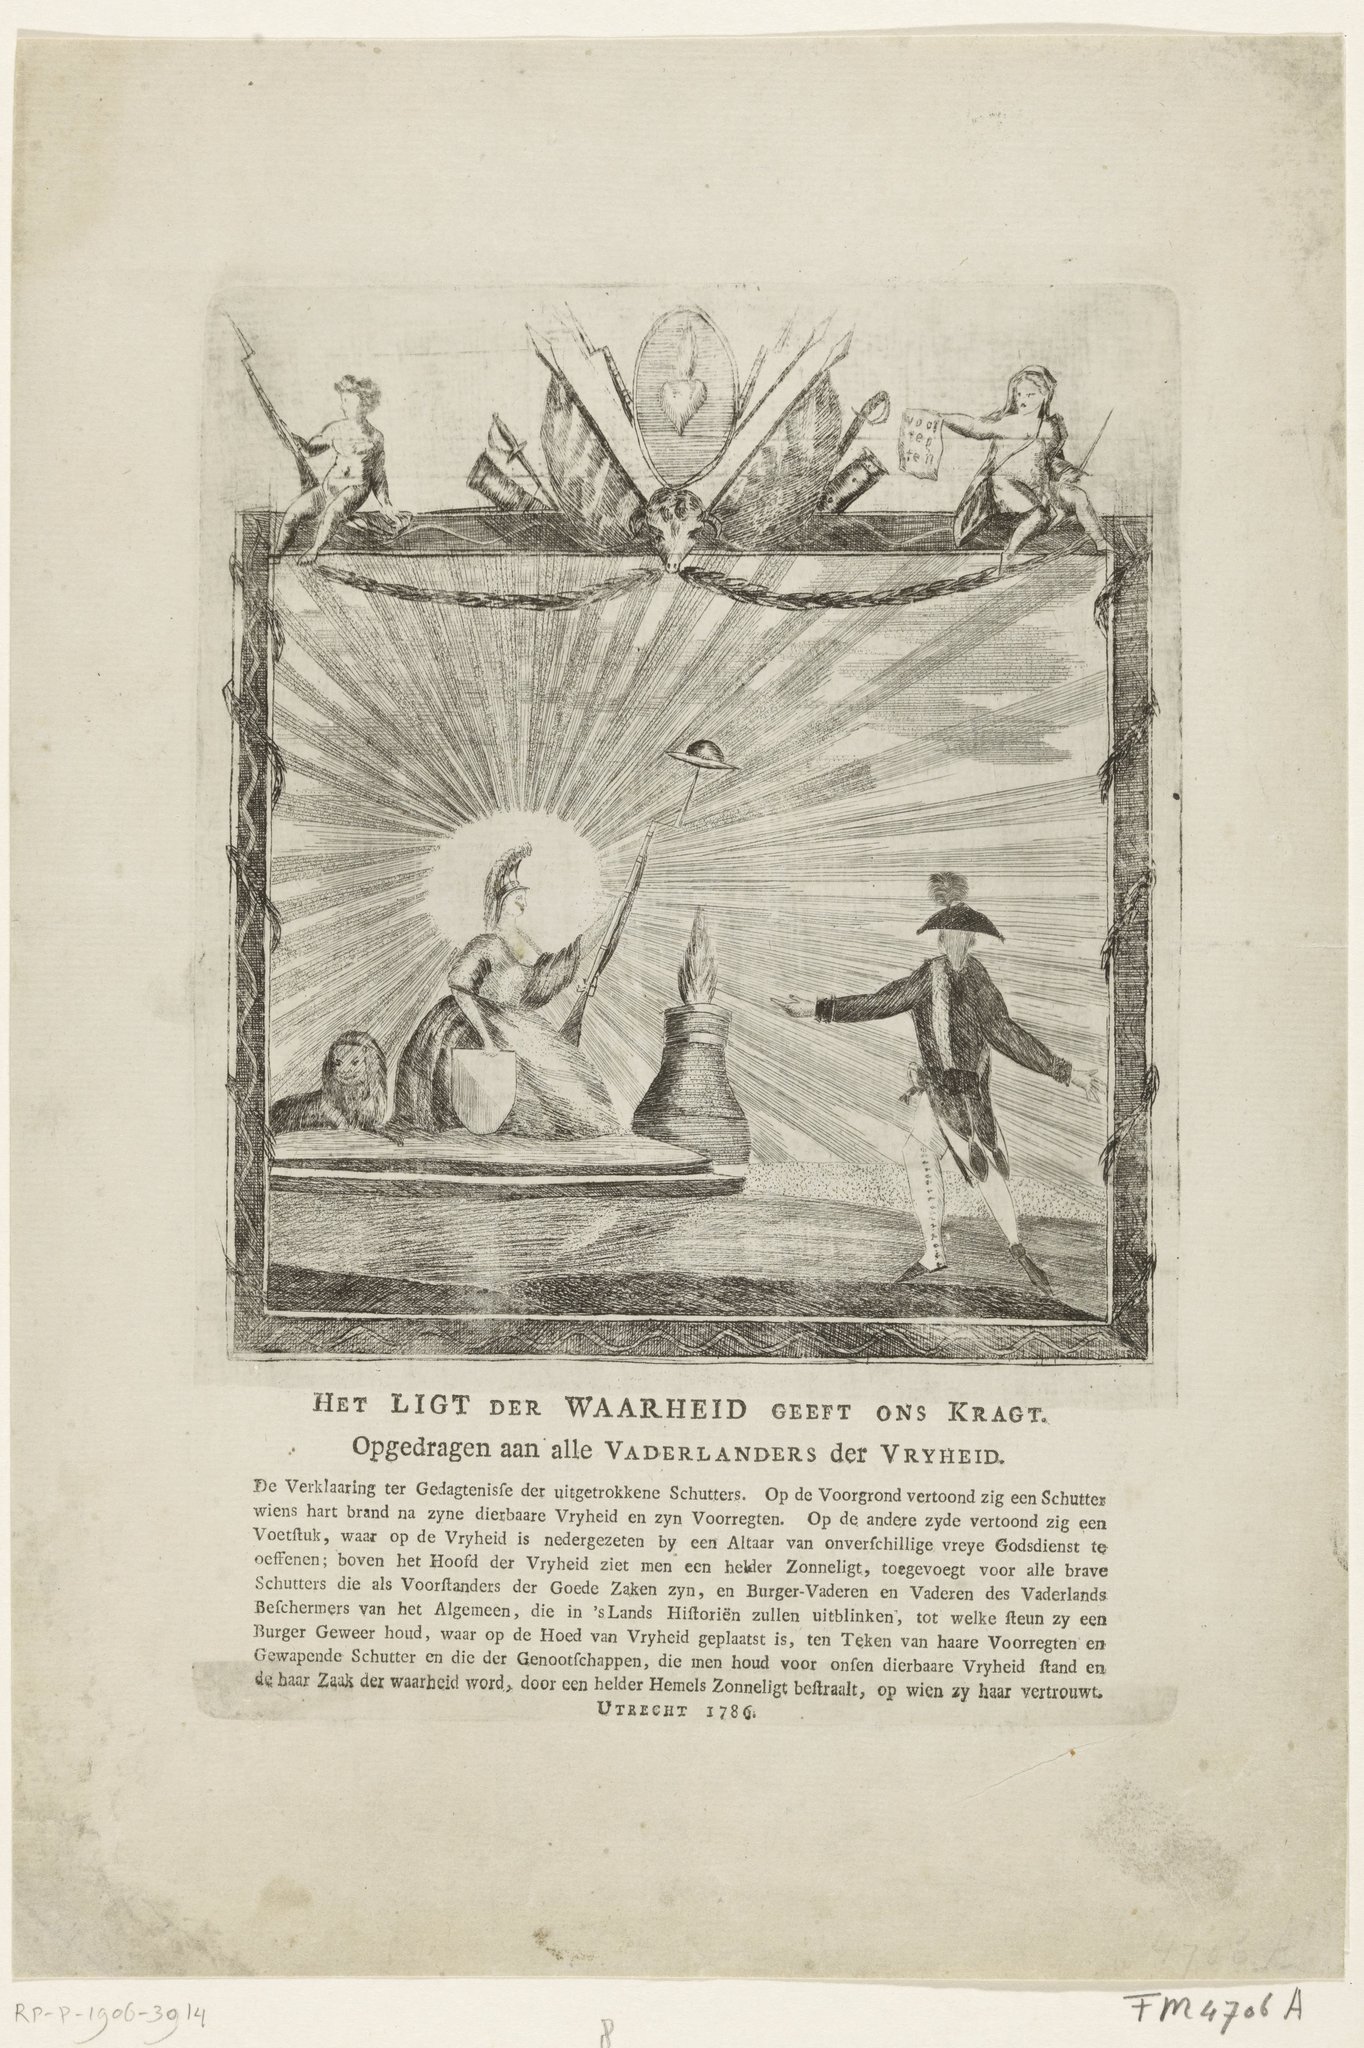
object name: print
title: Het Ligt der Waarheid geeft ons kragt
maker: Anonymous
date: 1786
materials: paper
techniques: engraving, etching, letterpress printing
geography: utrecht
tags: warfare; military affairs (+ citizen soldiery, civil guard, citizen militia), freedom, liberty; 'libertà' (ripa) (+ abstract concept represented by female figure), utrecht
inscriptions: collector's mark: Lugt 2228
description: Allegorie met een schutter staande voor de in zonlicht stralende Nederlandse Vrijheid gezeten op een altaar, 1786. Waarschijnlijk in verband met de inzwering van de schutterij te Utrecht op 20 maart 1786. Op het blad onder de plaat een verklaring van de voorstelling.